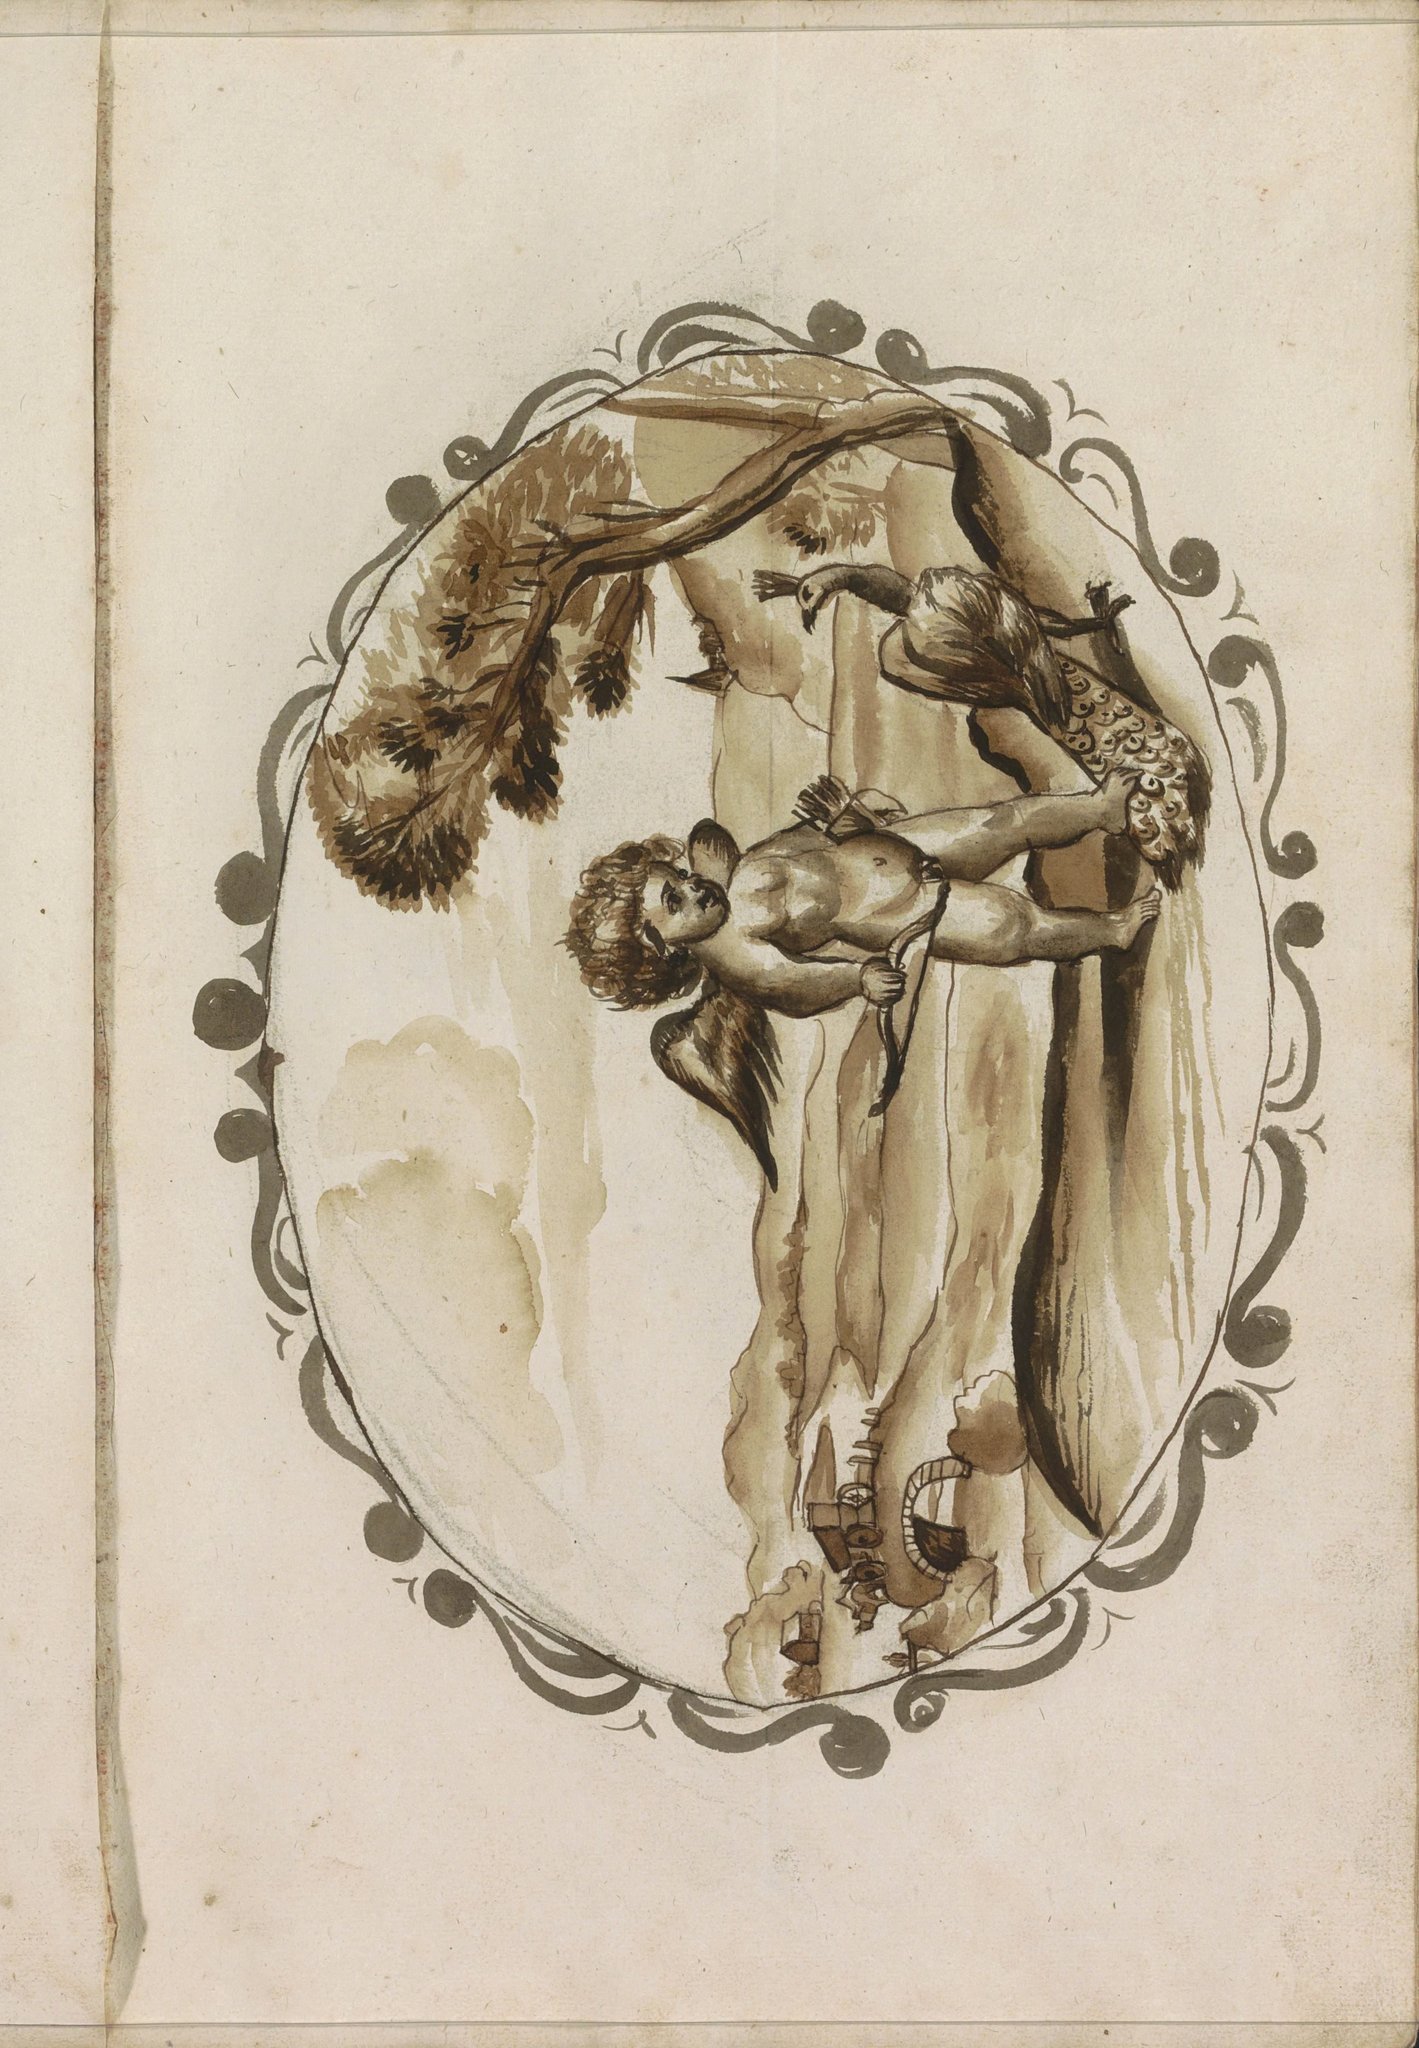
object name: sketchbook leaf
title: Putto met een pauw in een landschap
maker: hendrick van beaumont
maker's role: draughtsman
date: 1696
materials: ink, paper, watercolor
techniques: brush, pen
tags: city-view, and landscape with man-made constructions, ornamental birds: peacock, cupids: 'amores', 'amoretti', 'putti'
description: Op de achtergrond een kar op een brug. Tekening in een omlijsting, mogelijk naar een prent. Blad 66 recto uit een schetsboek met 91 bladen.